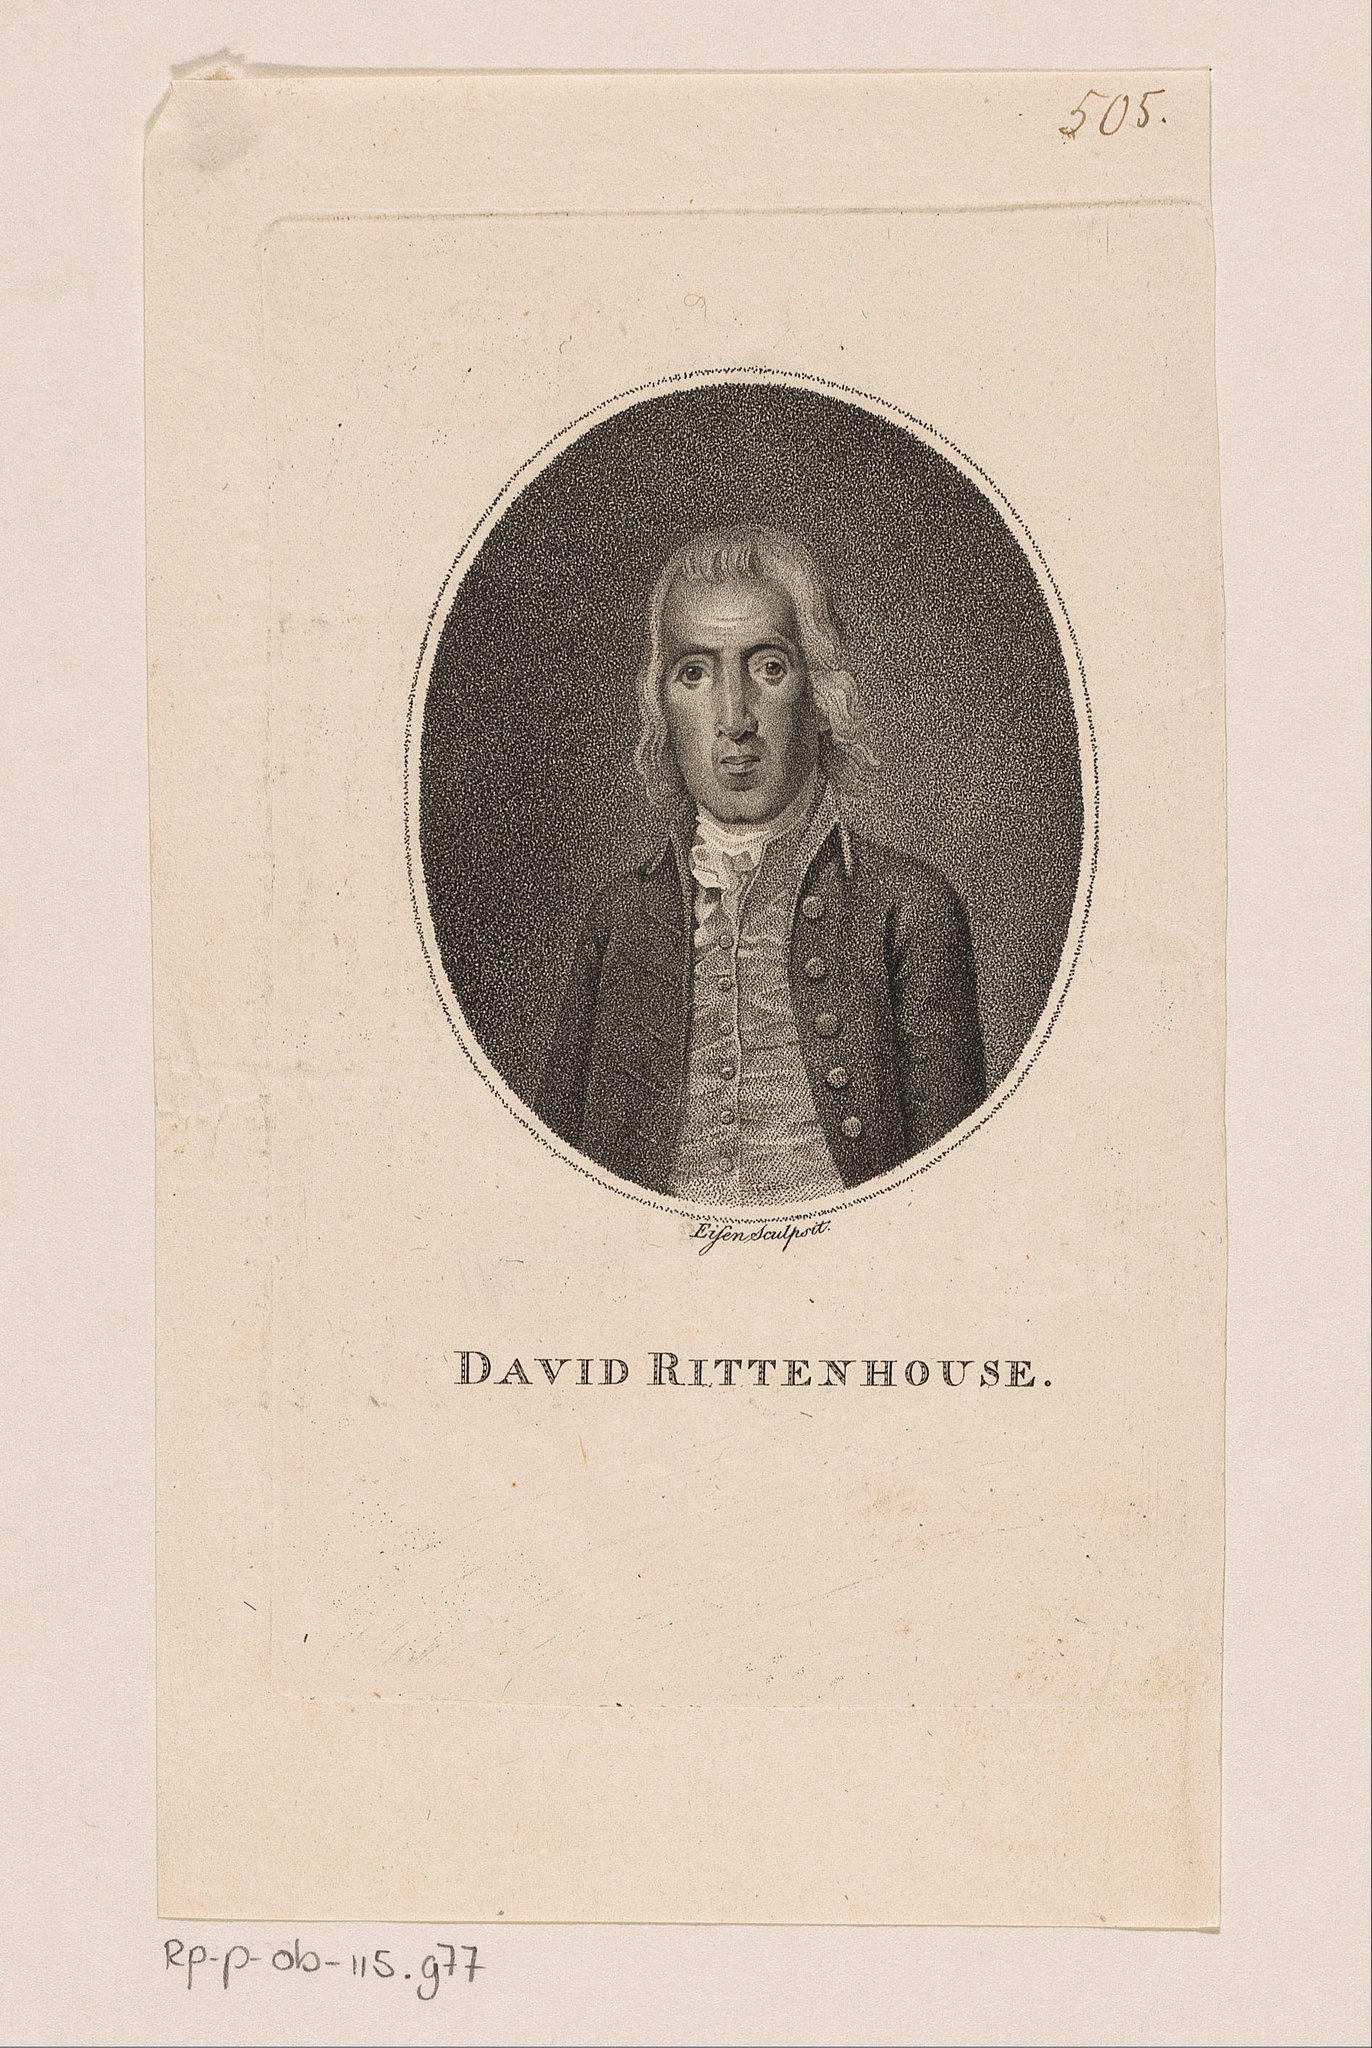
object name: print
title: Portret van David Rittenhouse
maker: anton paul eisen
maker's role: print maker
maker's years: 1777-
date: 1787-1843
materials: paper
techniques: stippling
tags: historical persons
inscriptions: collector's mark: Lugt 2228